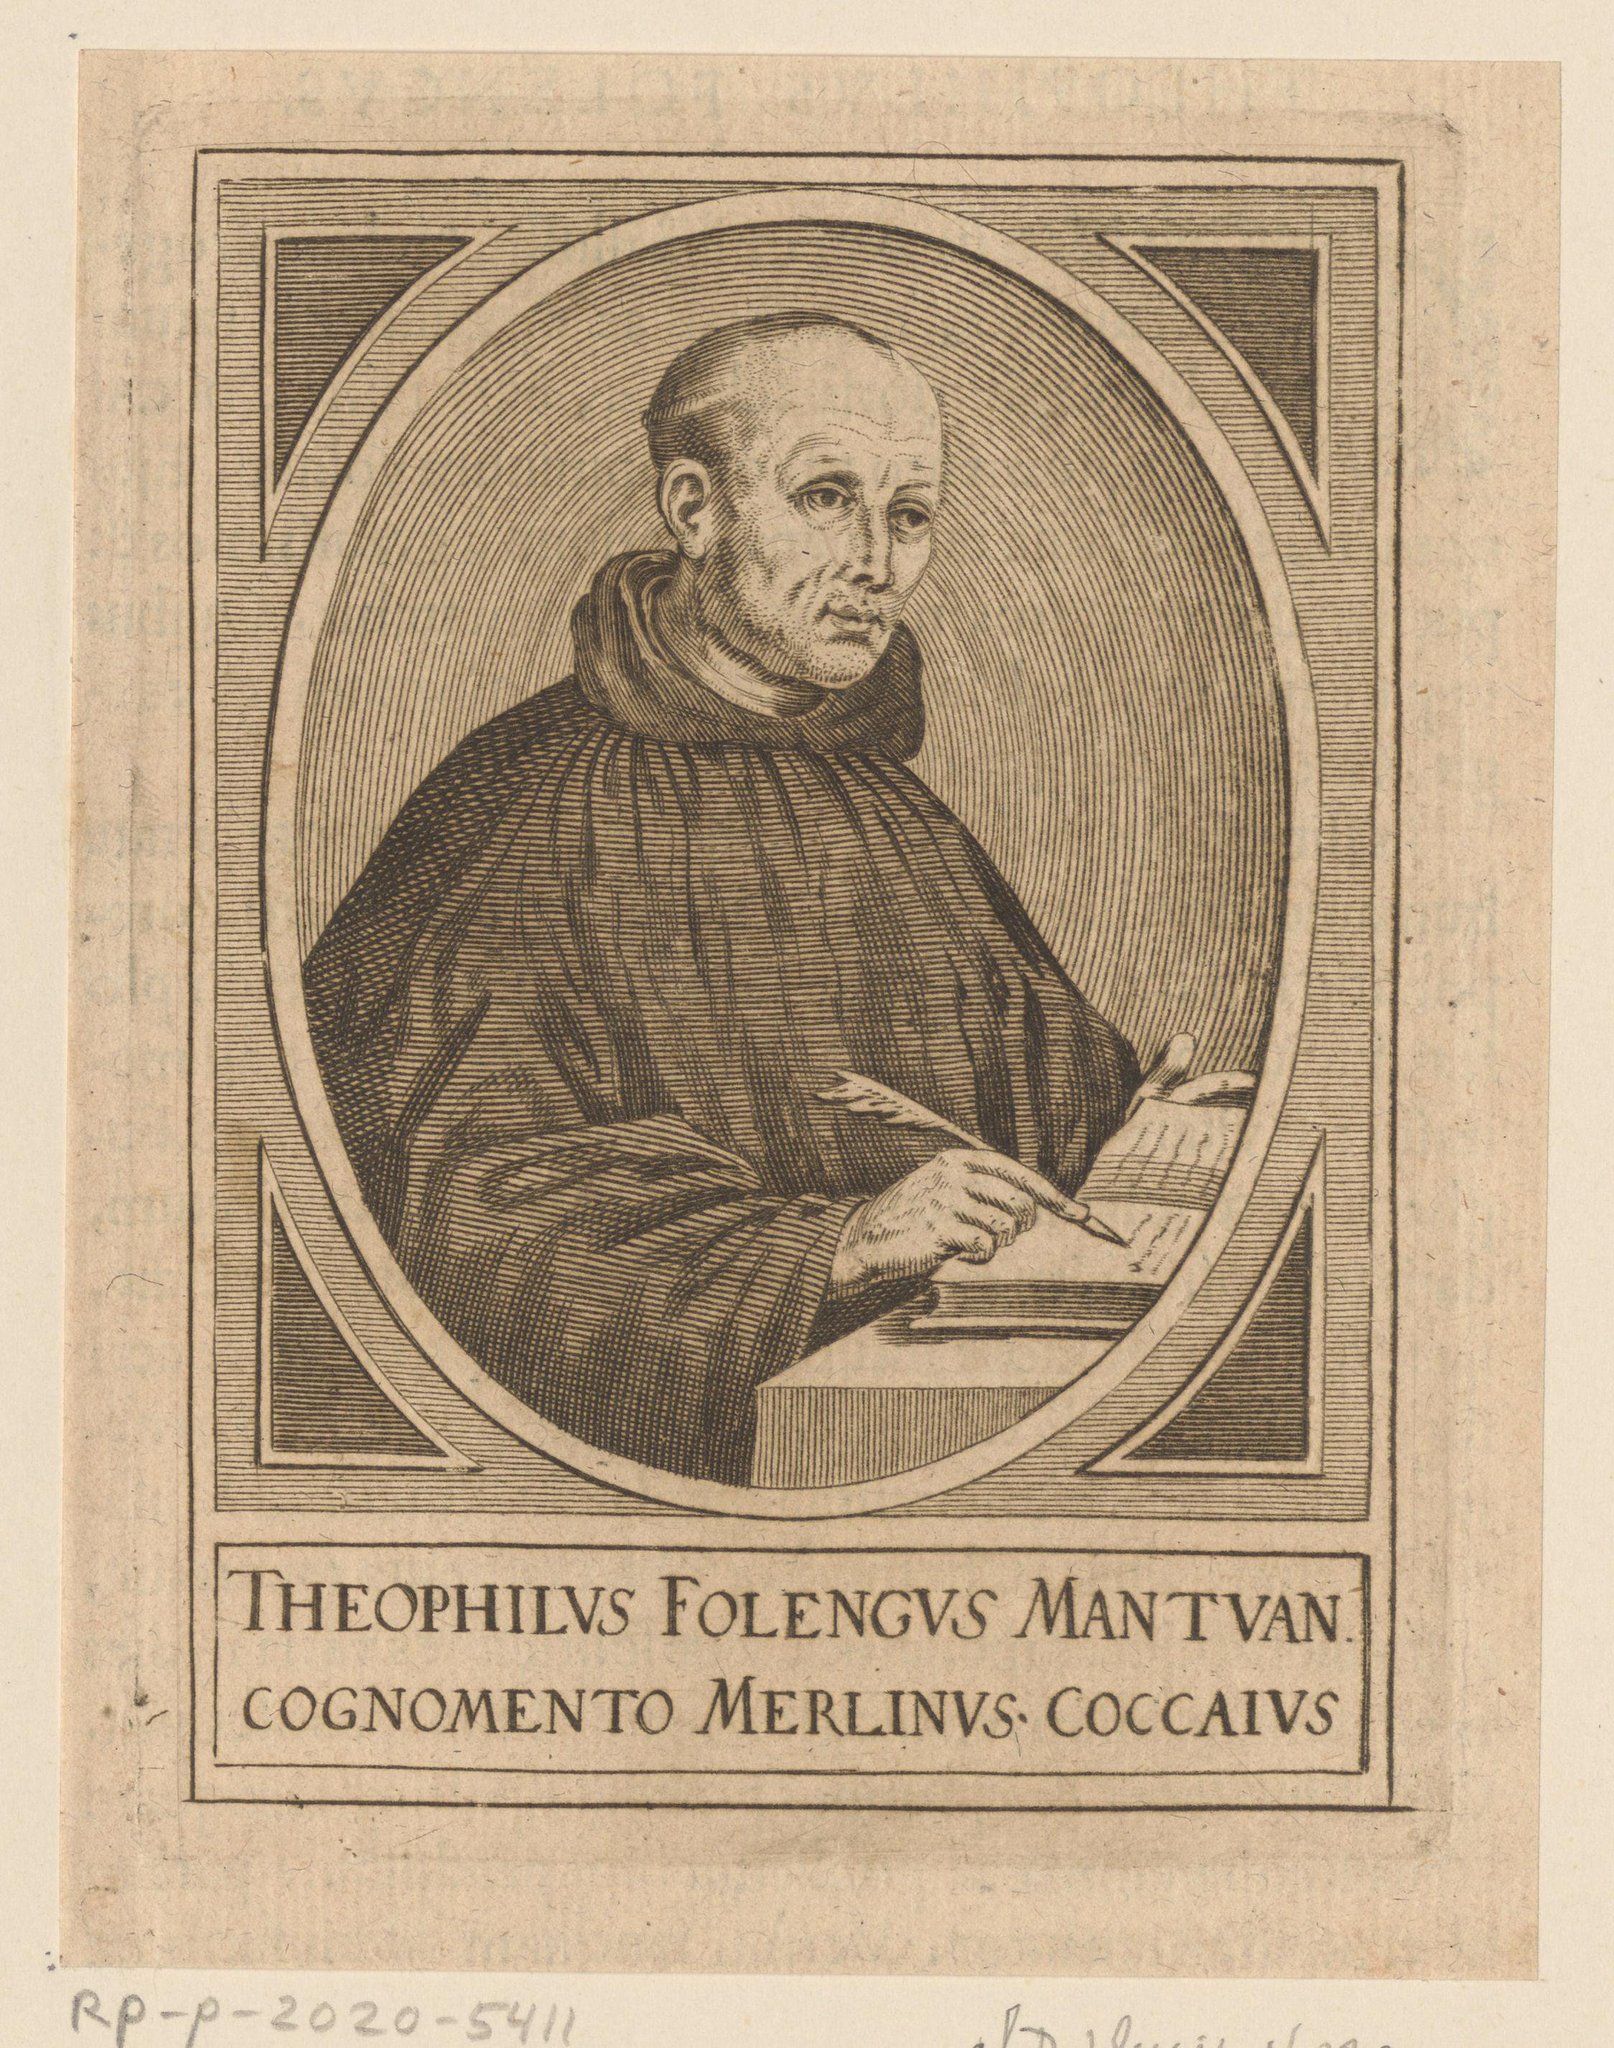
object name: print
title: Portret van Teofilo Folengo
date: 1644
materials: paper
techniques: engraving, etching, letterpress printing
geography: italy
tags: handwriting, writing as activity, historical persons, portrait of a writer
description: Prent uit: Tomasini, Giacomo Filippo. Elogia virorum literis et sapientia illustrium (...). Padua: Sebastiano Sardi, 1644, p. 71.